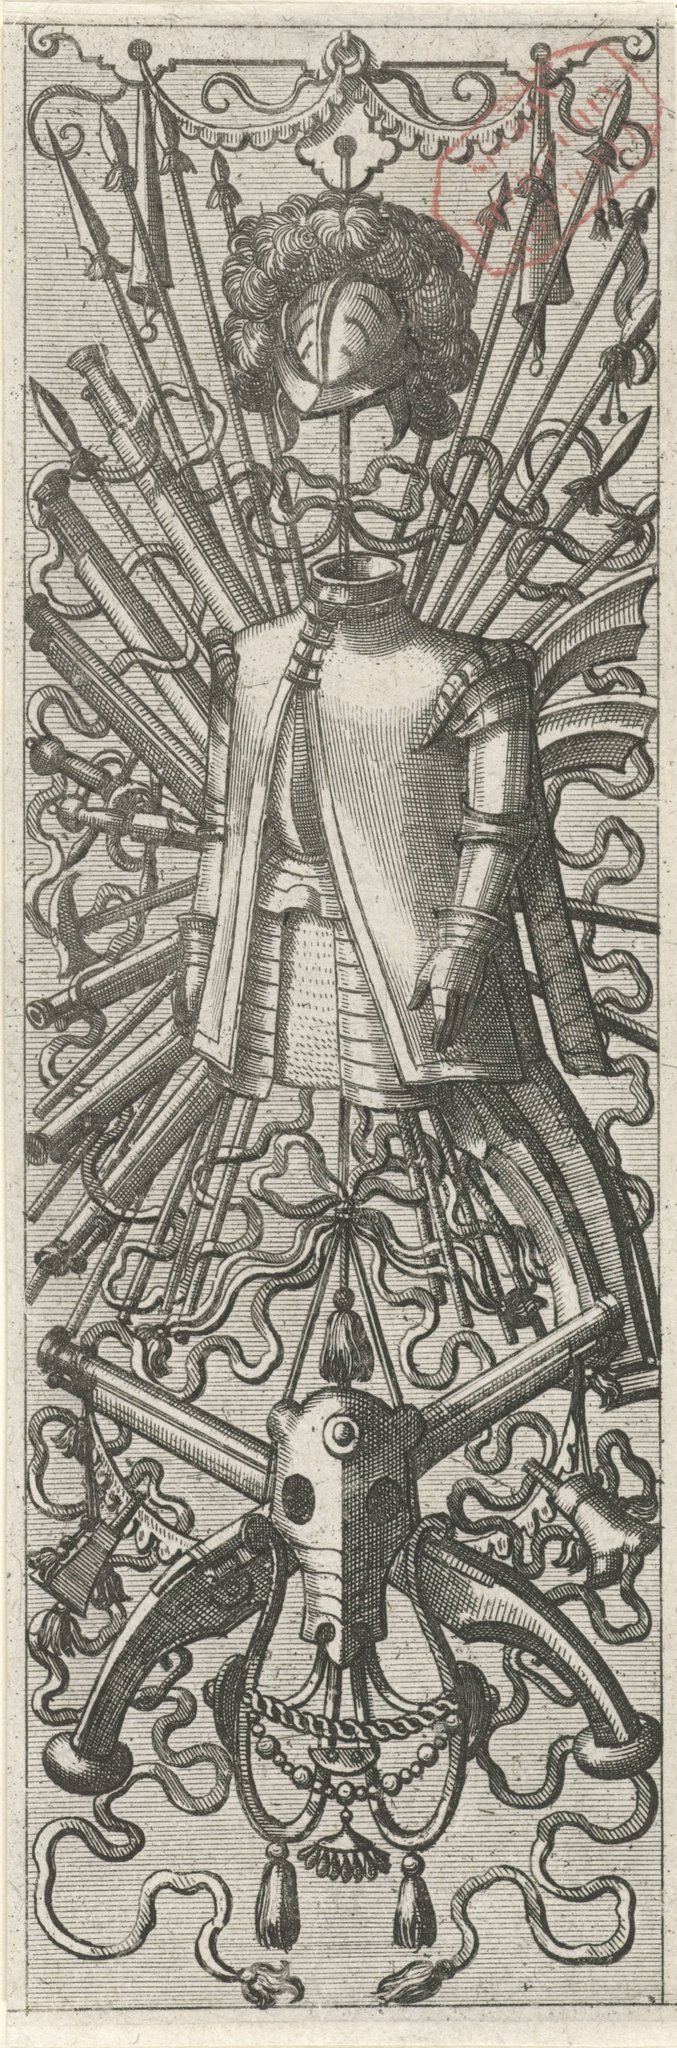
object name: ornament print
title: Panoplia sev armamentarium…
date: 1572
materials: paper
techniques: etching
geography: netherlands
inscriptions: collector's mark: Lugt 2275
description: Trofee met diverse steekwapens en de beschermkap voor een paardenhoofd. Uit serie, bestaande uit een titelblad en 16 bladen.